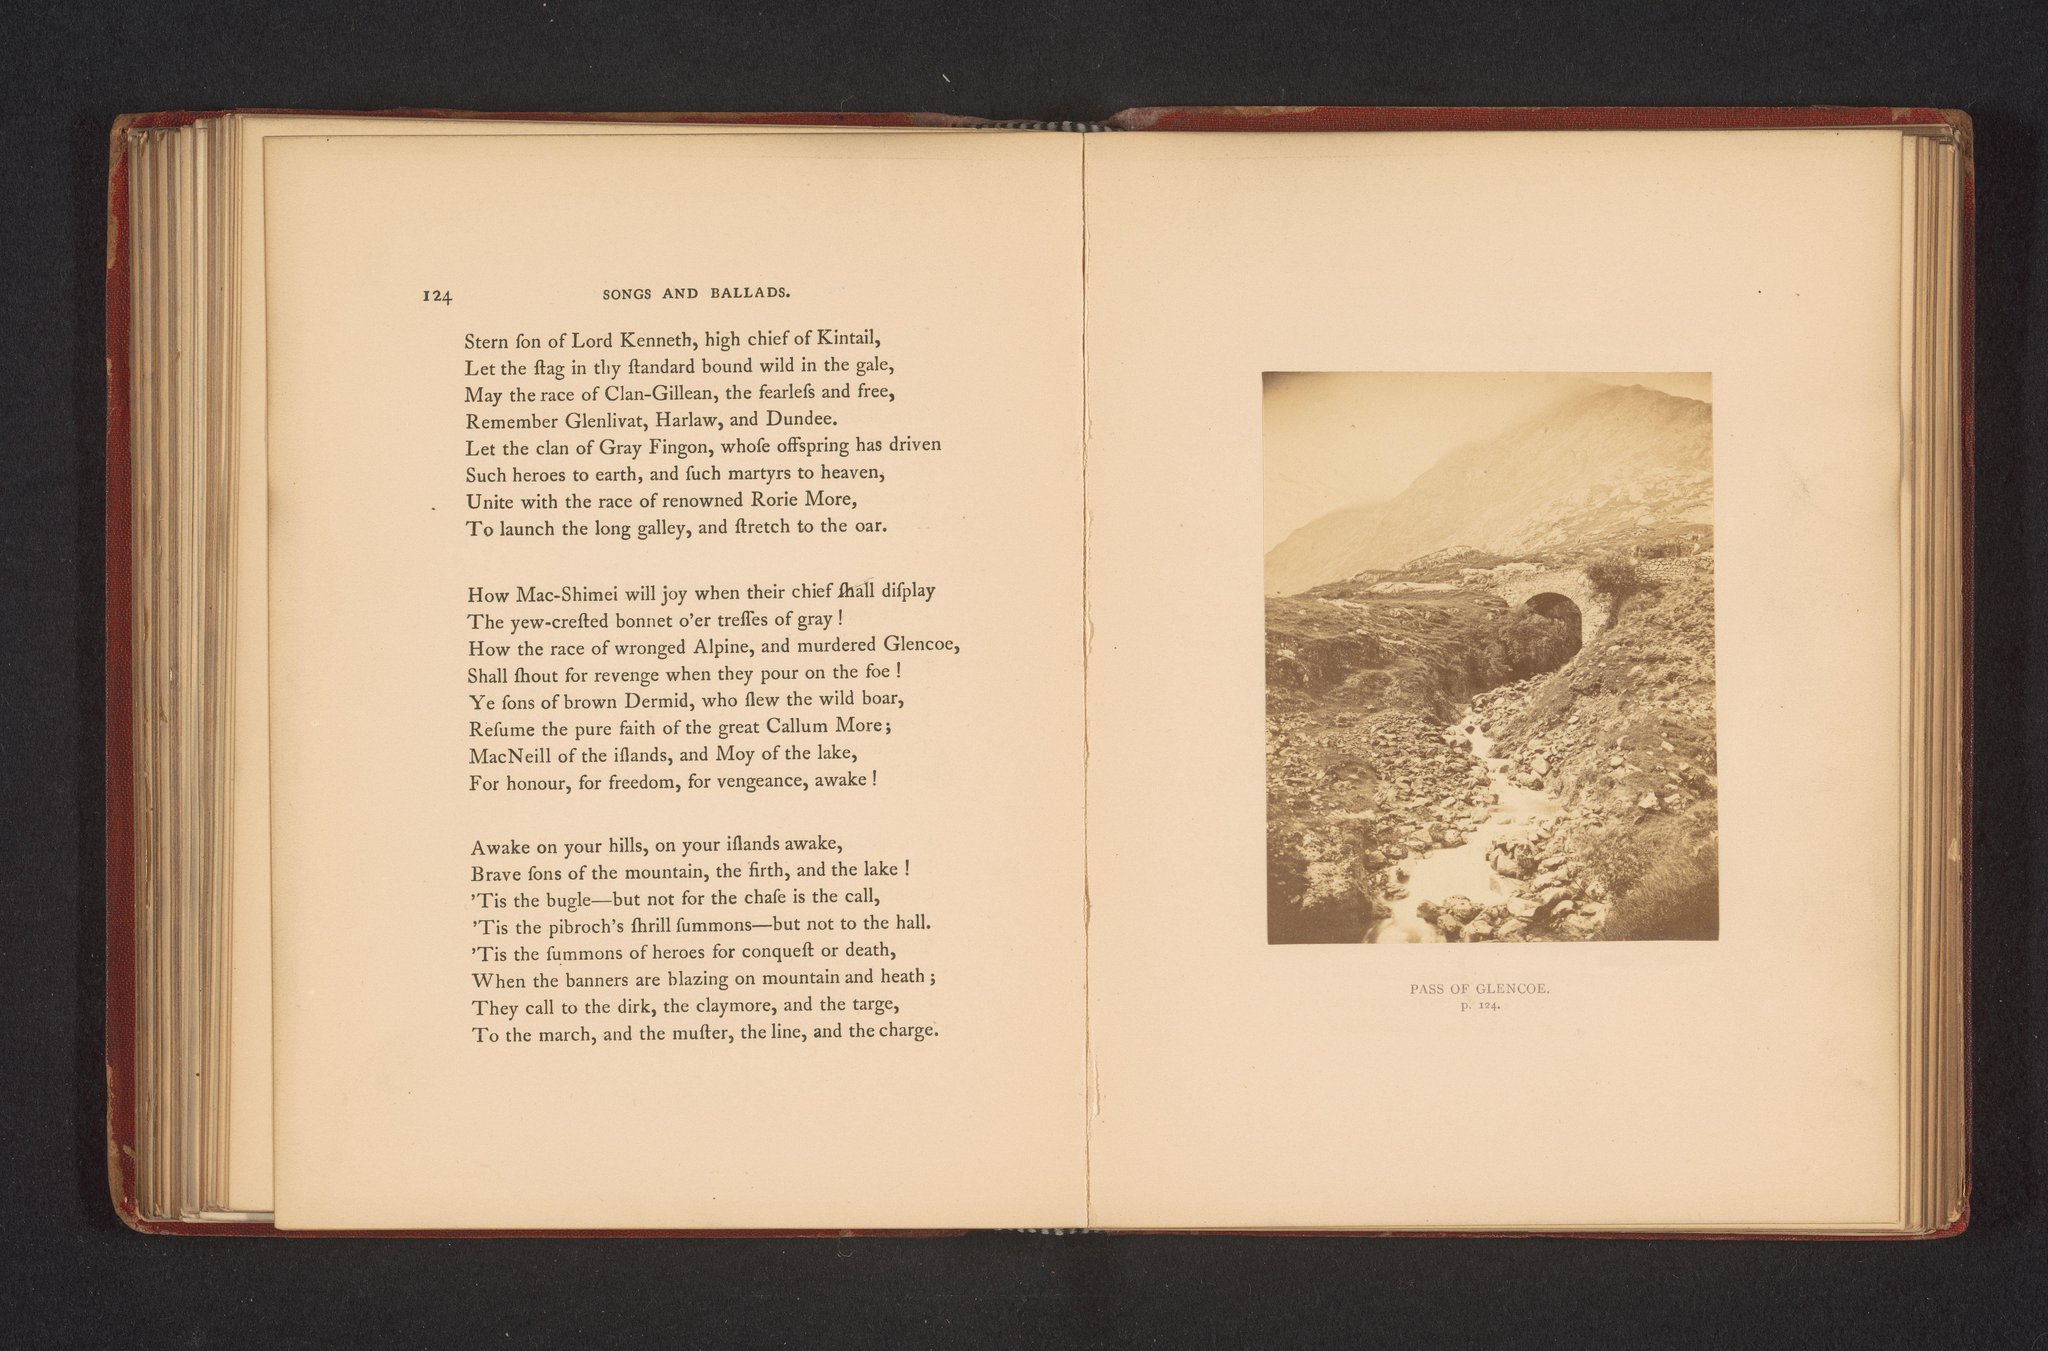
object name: page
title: Pass of Glencoe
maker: stephen thompson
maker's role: fotograaf, schrijver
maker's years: 1831-1893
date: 1863-1868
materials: photographic support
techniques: albumen print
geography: glen coe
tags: dale, valley, bridge